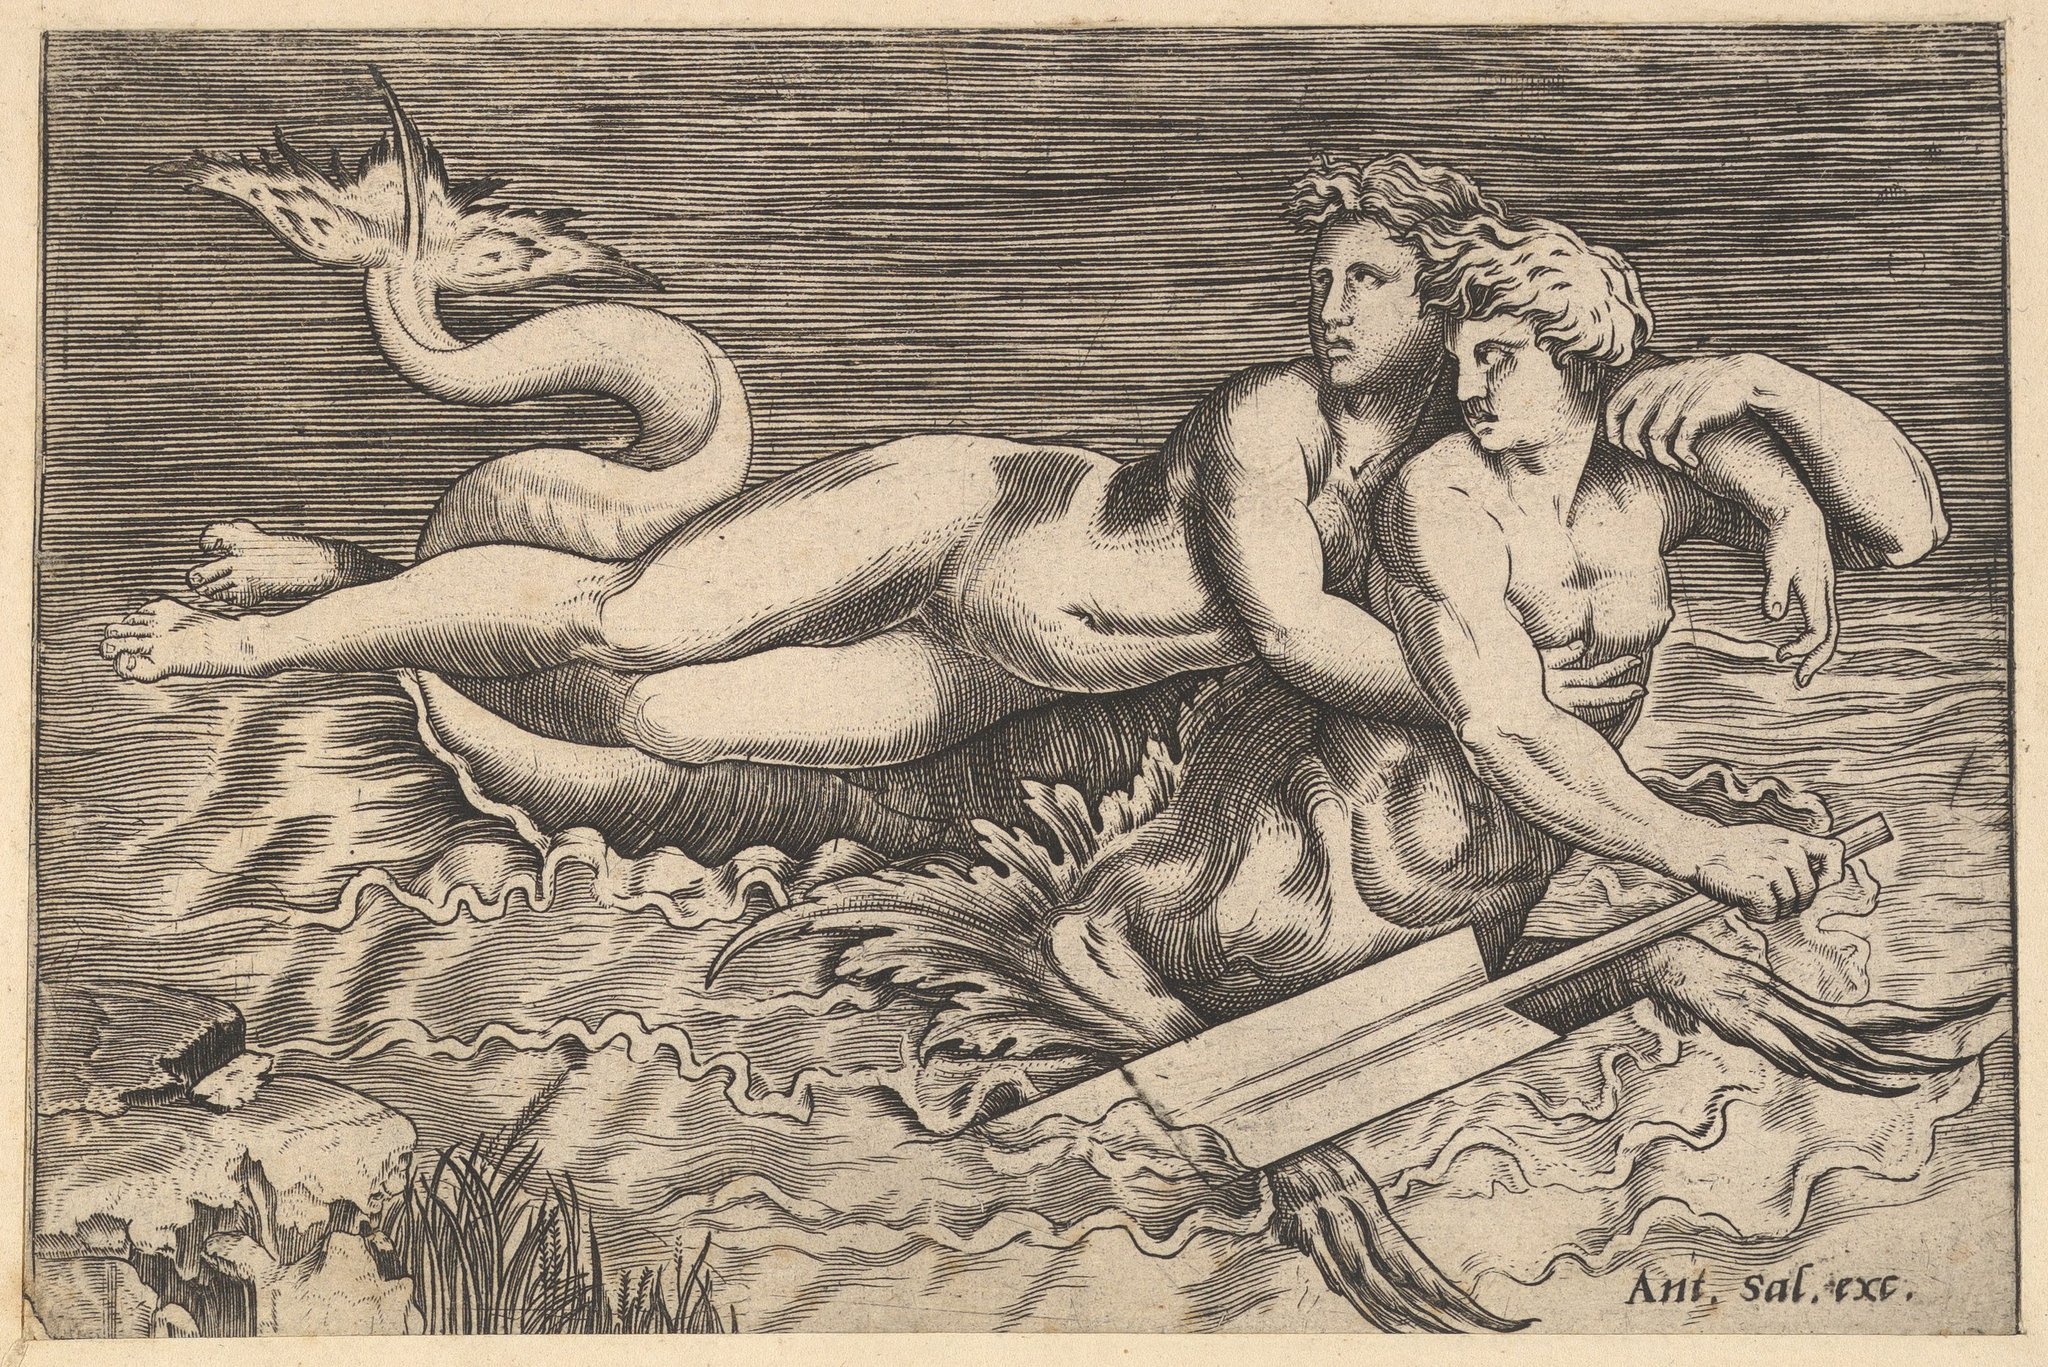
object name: print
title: A Triton Carrying off a Nymph, from "Speculum Romanae Magnificentiae"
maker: marco dente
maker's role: artist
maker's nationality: italian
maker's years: 1515-1527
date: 1501-1600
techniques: engraving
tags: triton,nymphs